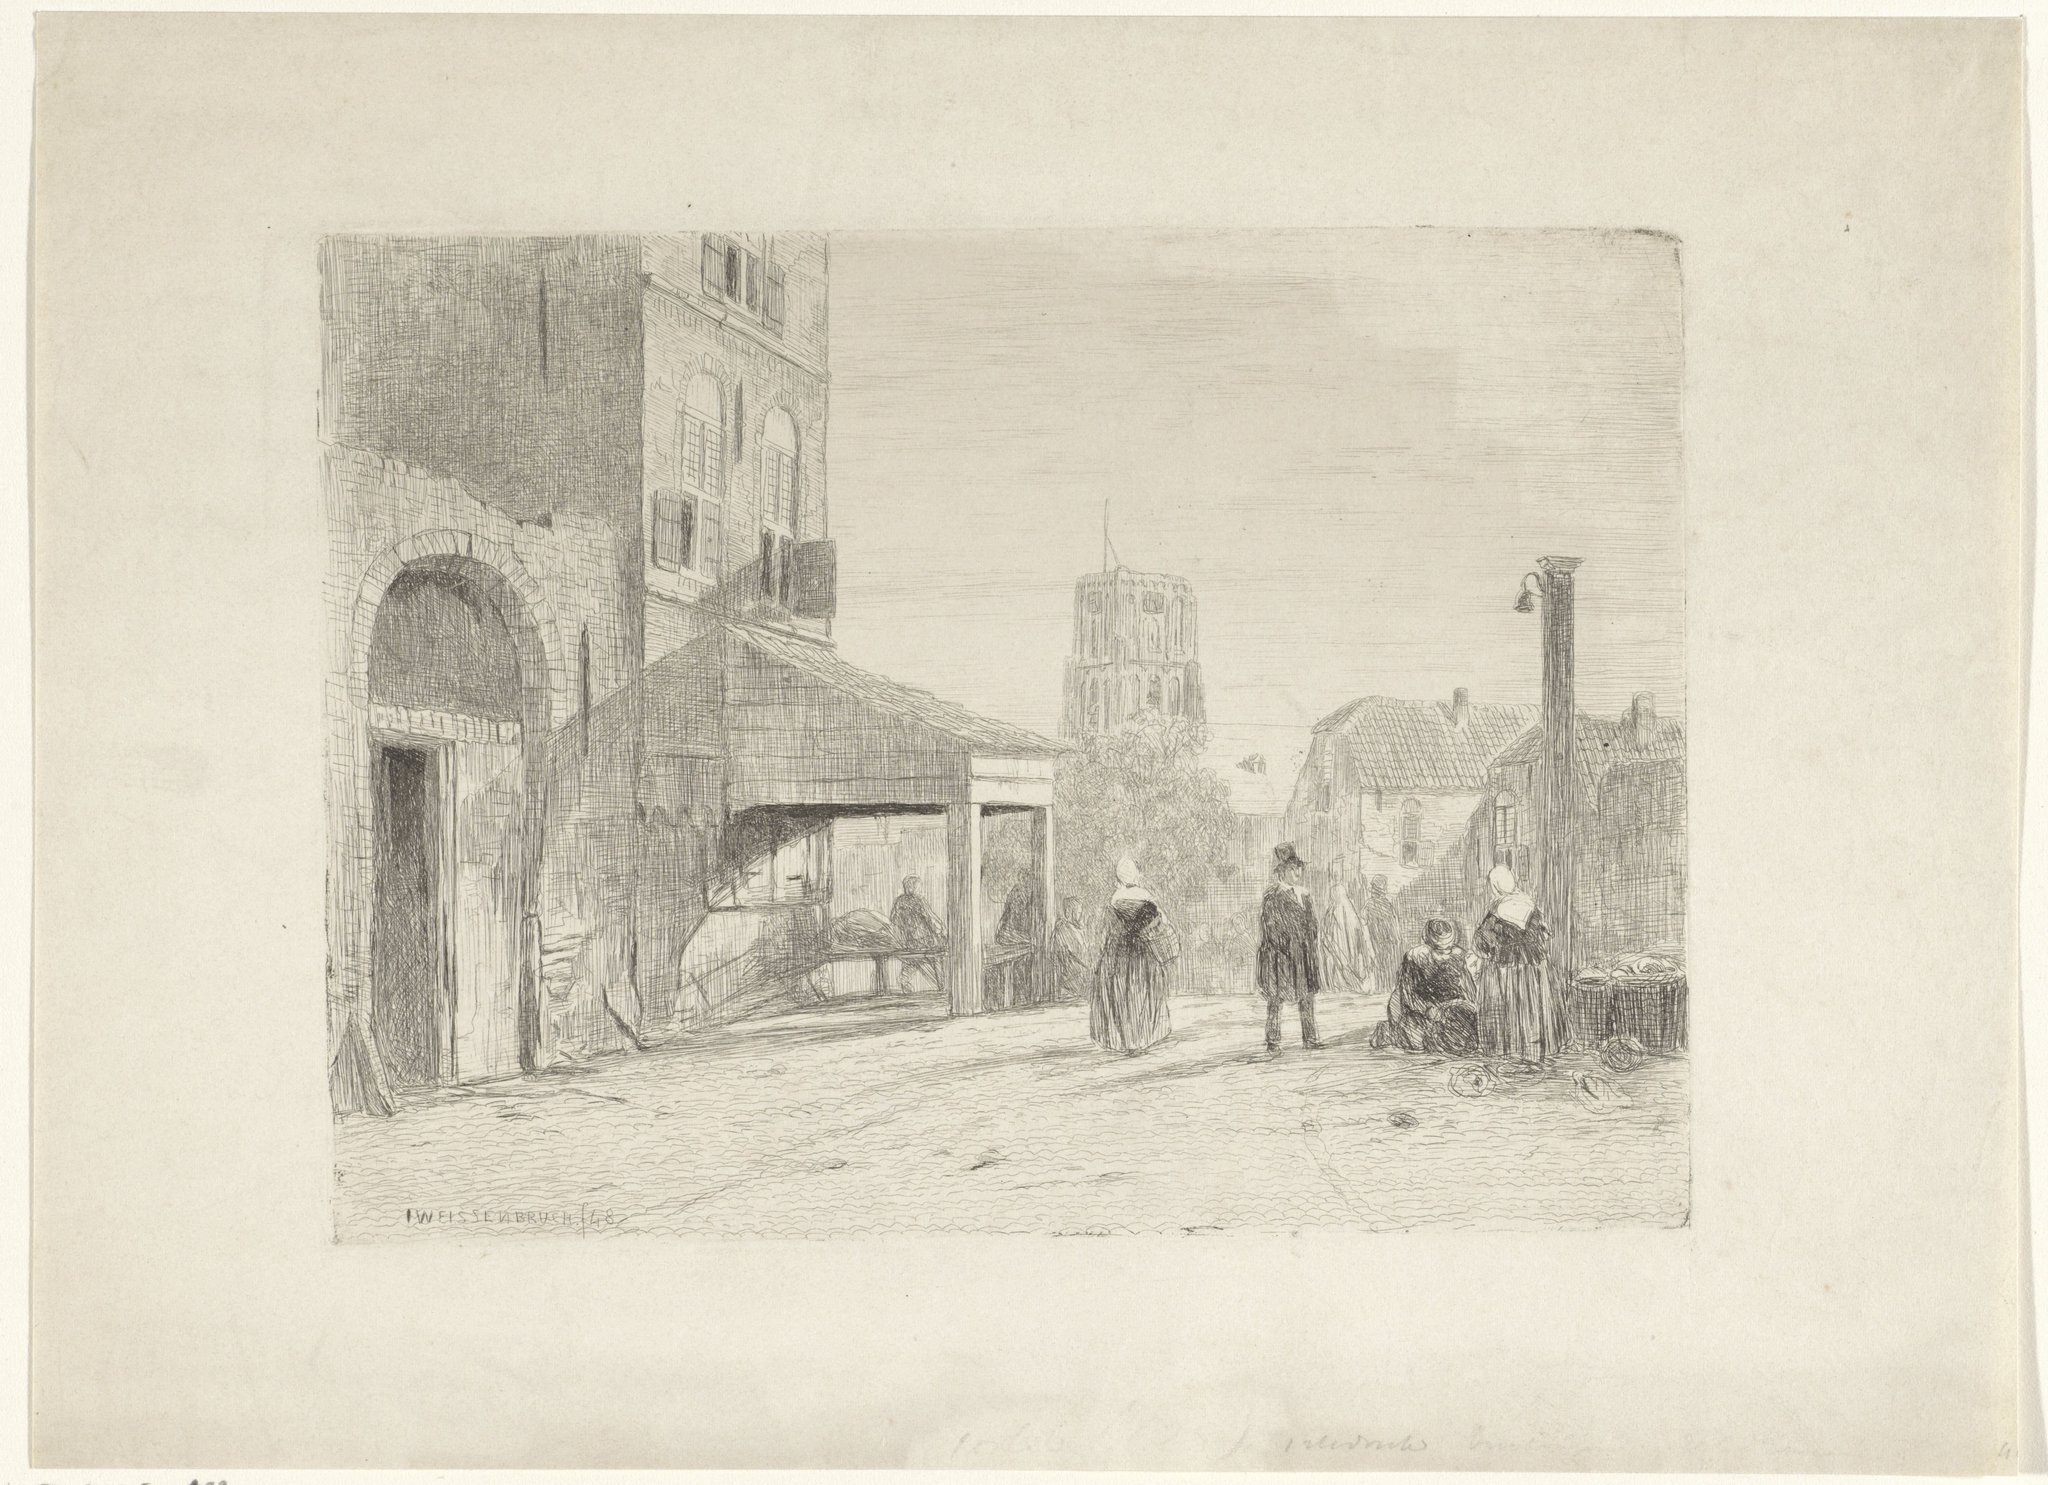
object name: print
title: Gezicht op de Sint-Martinuskerk te Woudrichem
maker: jan weissenbruch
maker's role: painter, print maker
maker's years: 1822-1880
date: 1848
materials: paper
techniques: etching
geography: the hague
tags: urban housing, adult woman, adult man, container made of plant material other than wood: basket, church (exterior), parts of church exterior and annexes, village square, place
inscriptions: date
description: Aan een dorpsplein staan enkele huizen. Rechts bevinden zich enkele figuren met manden rondom een paal met een lantaarn of een bel. In de verte is de Sint-Martinuskerk te zien.